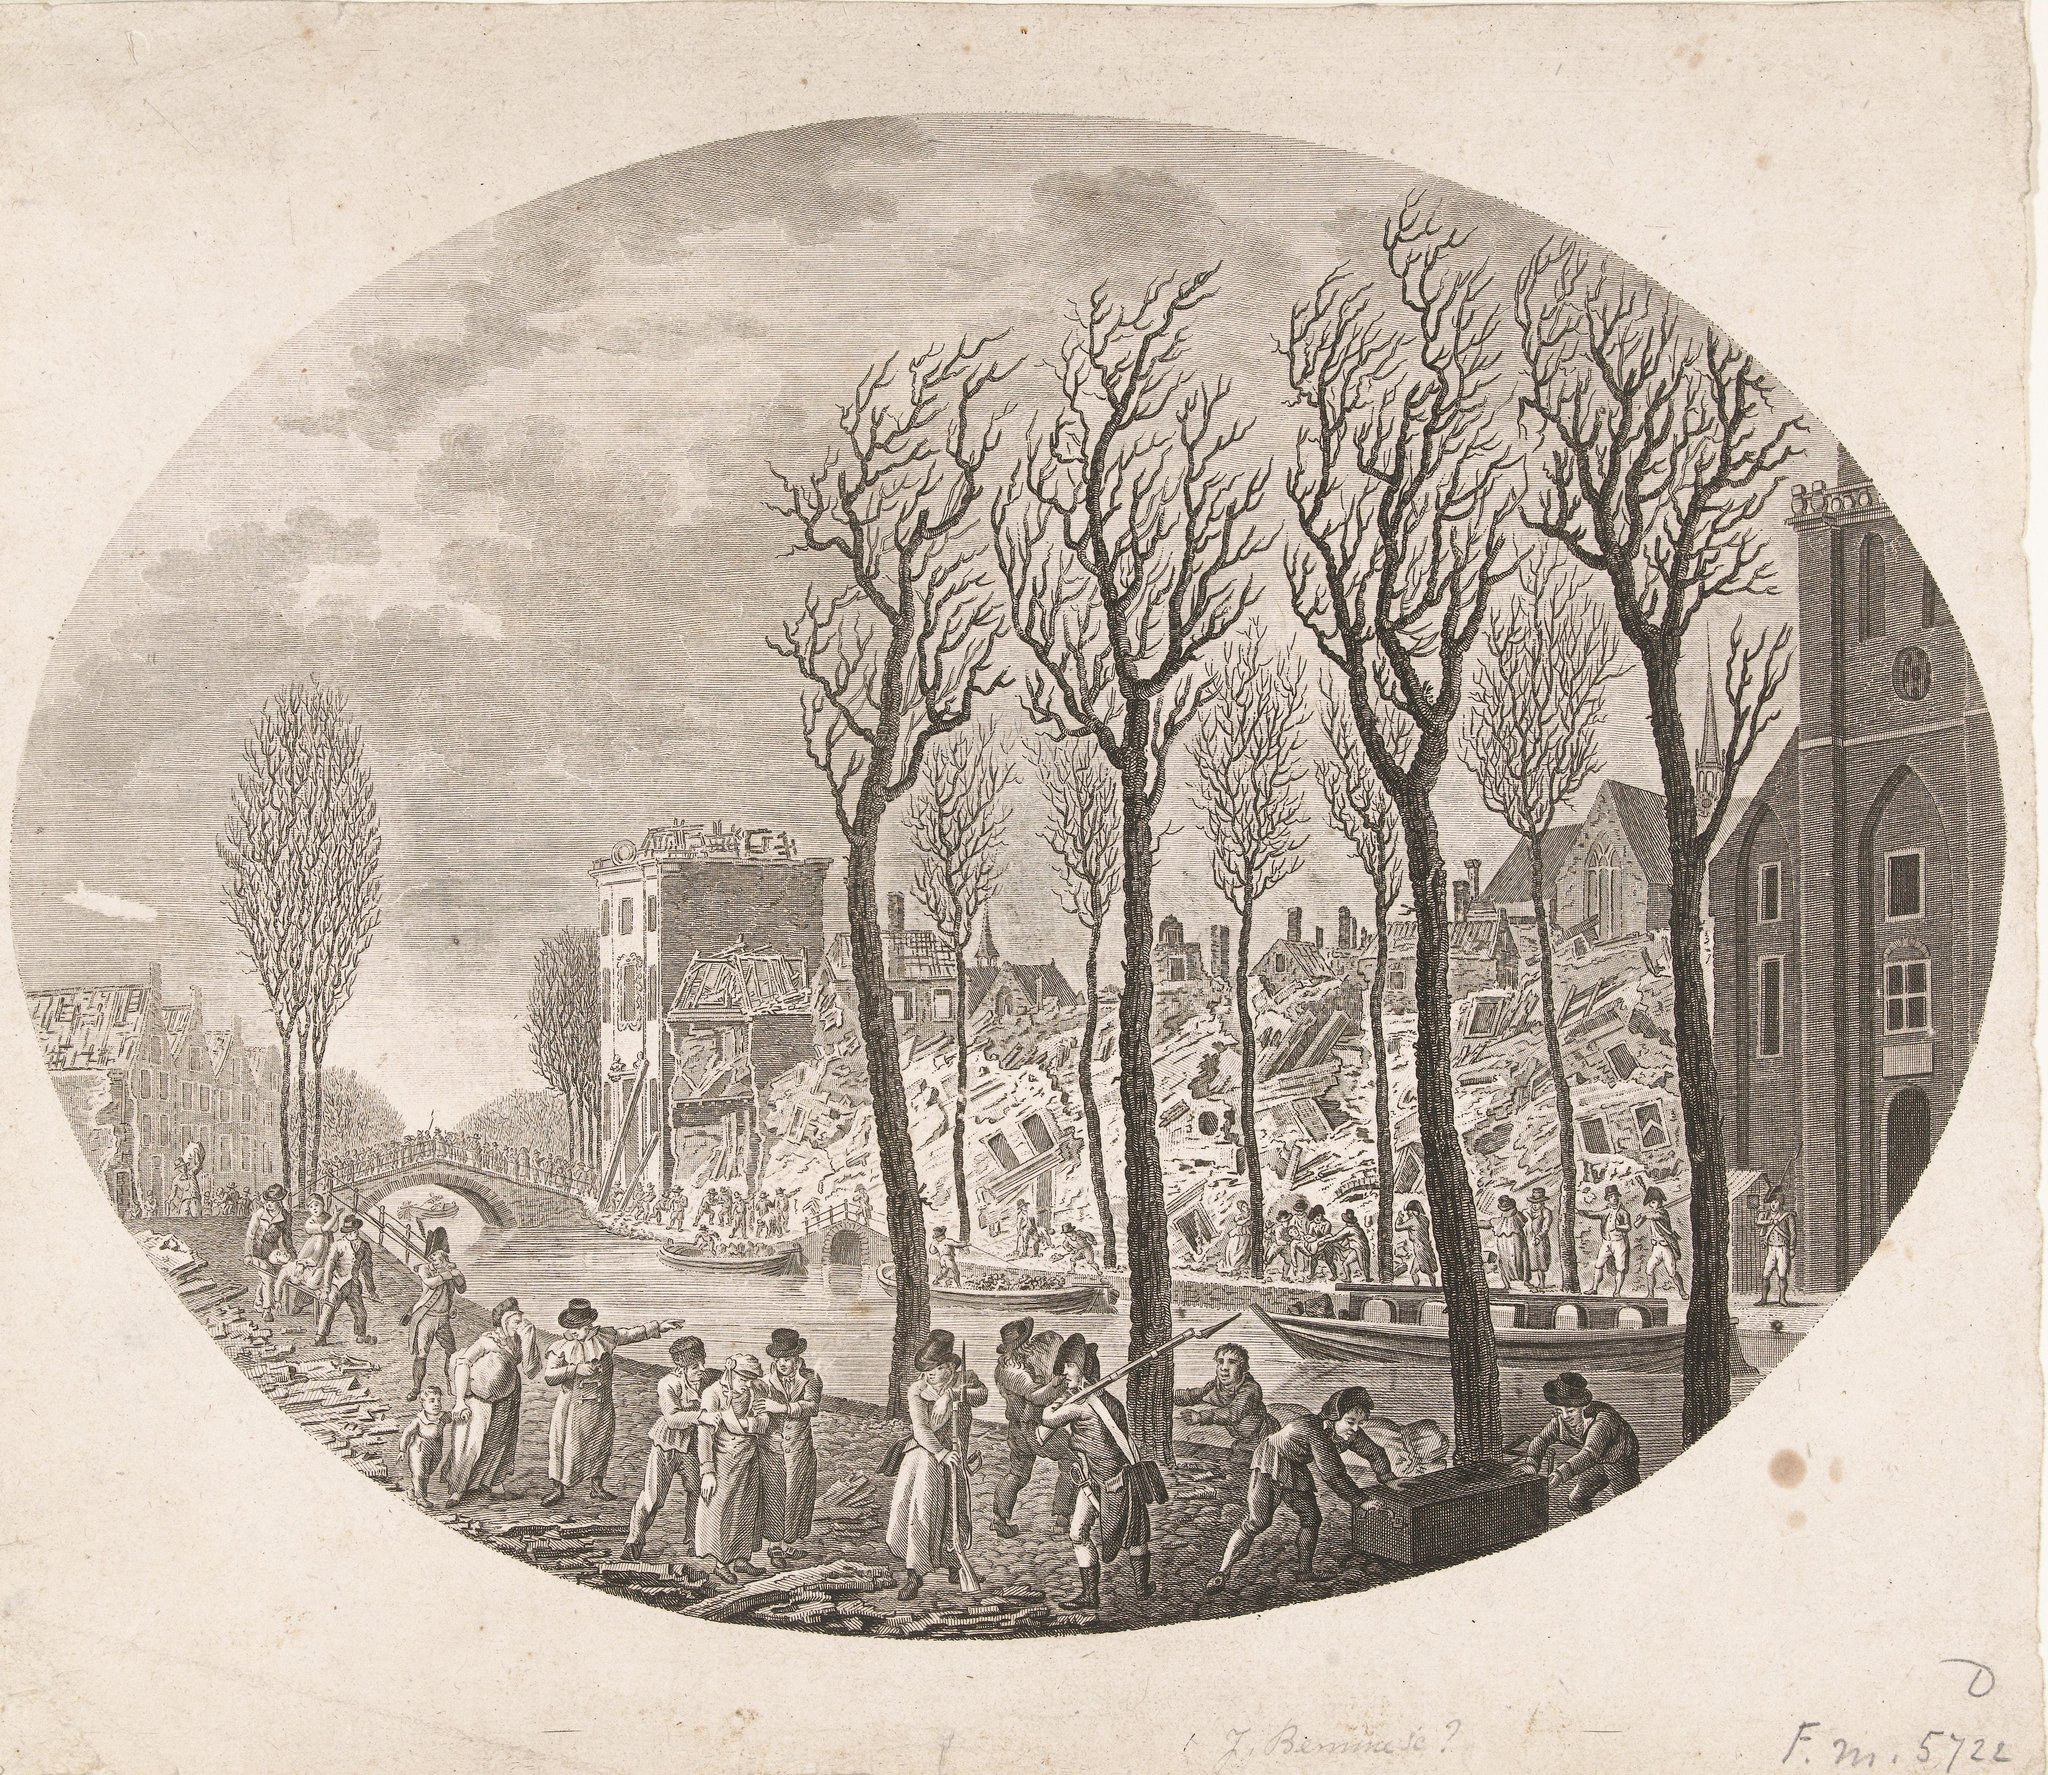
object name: print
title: Puinhopen aan het Rapenburg na de ramp van Leiden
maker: joannes bemme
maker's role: print maker, printer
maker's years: 1775-1841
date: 1807-1809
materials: paper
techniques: etching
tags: crafts and industries (+ accidental destruction, failing of production), leiden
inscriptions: collector's mark: Lugt 2228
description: Gezicht op het Steenschuur, een gracht in het verlengde van het Rapenburg, te Leiden na de ramp met het kruitschip. Aan de overzijde van het water de puinhopen van de vernietigde huizen. Uit het puin worden nog steeds lichamen geborgen. Op de voorgrond zijn burgers en soldaten bezig gewonden te helpen.